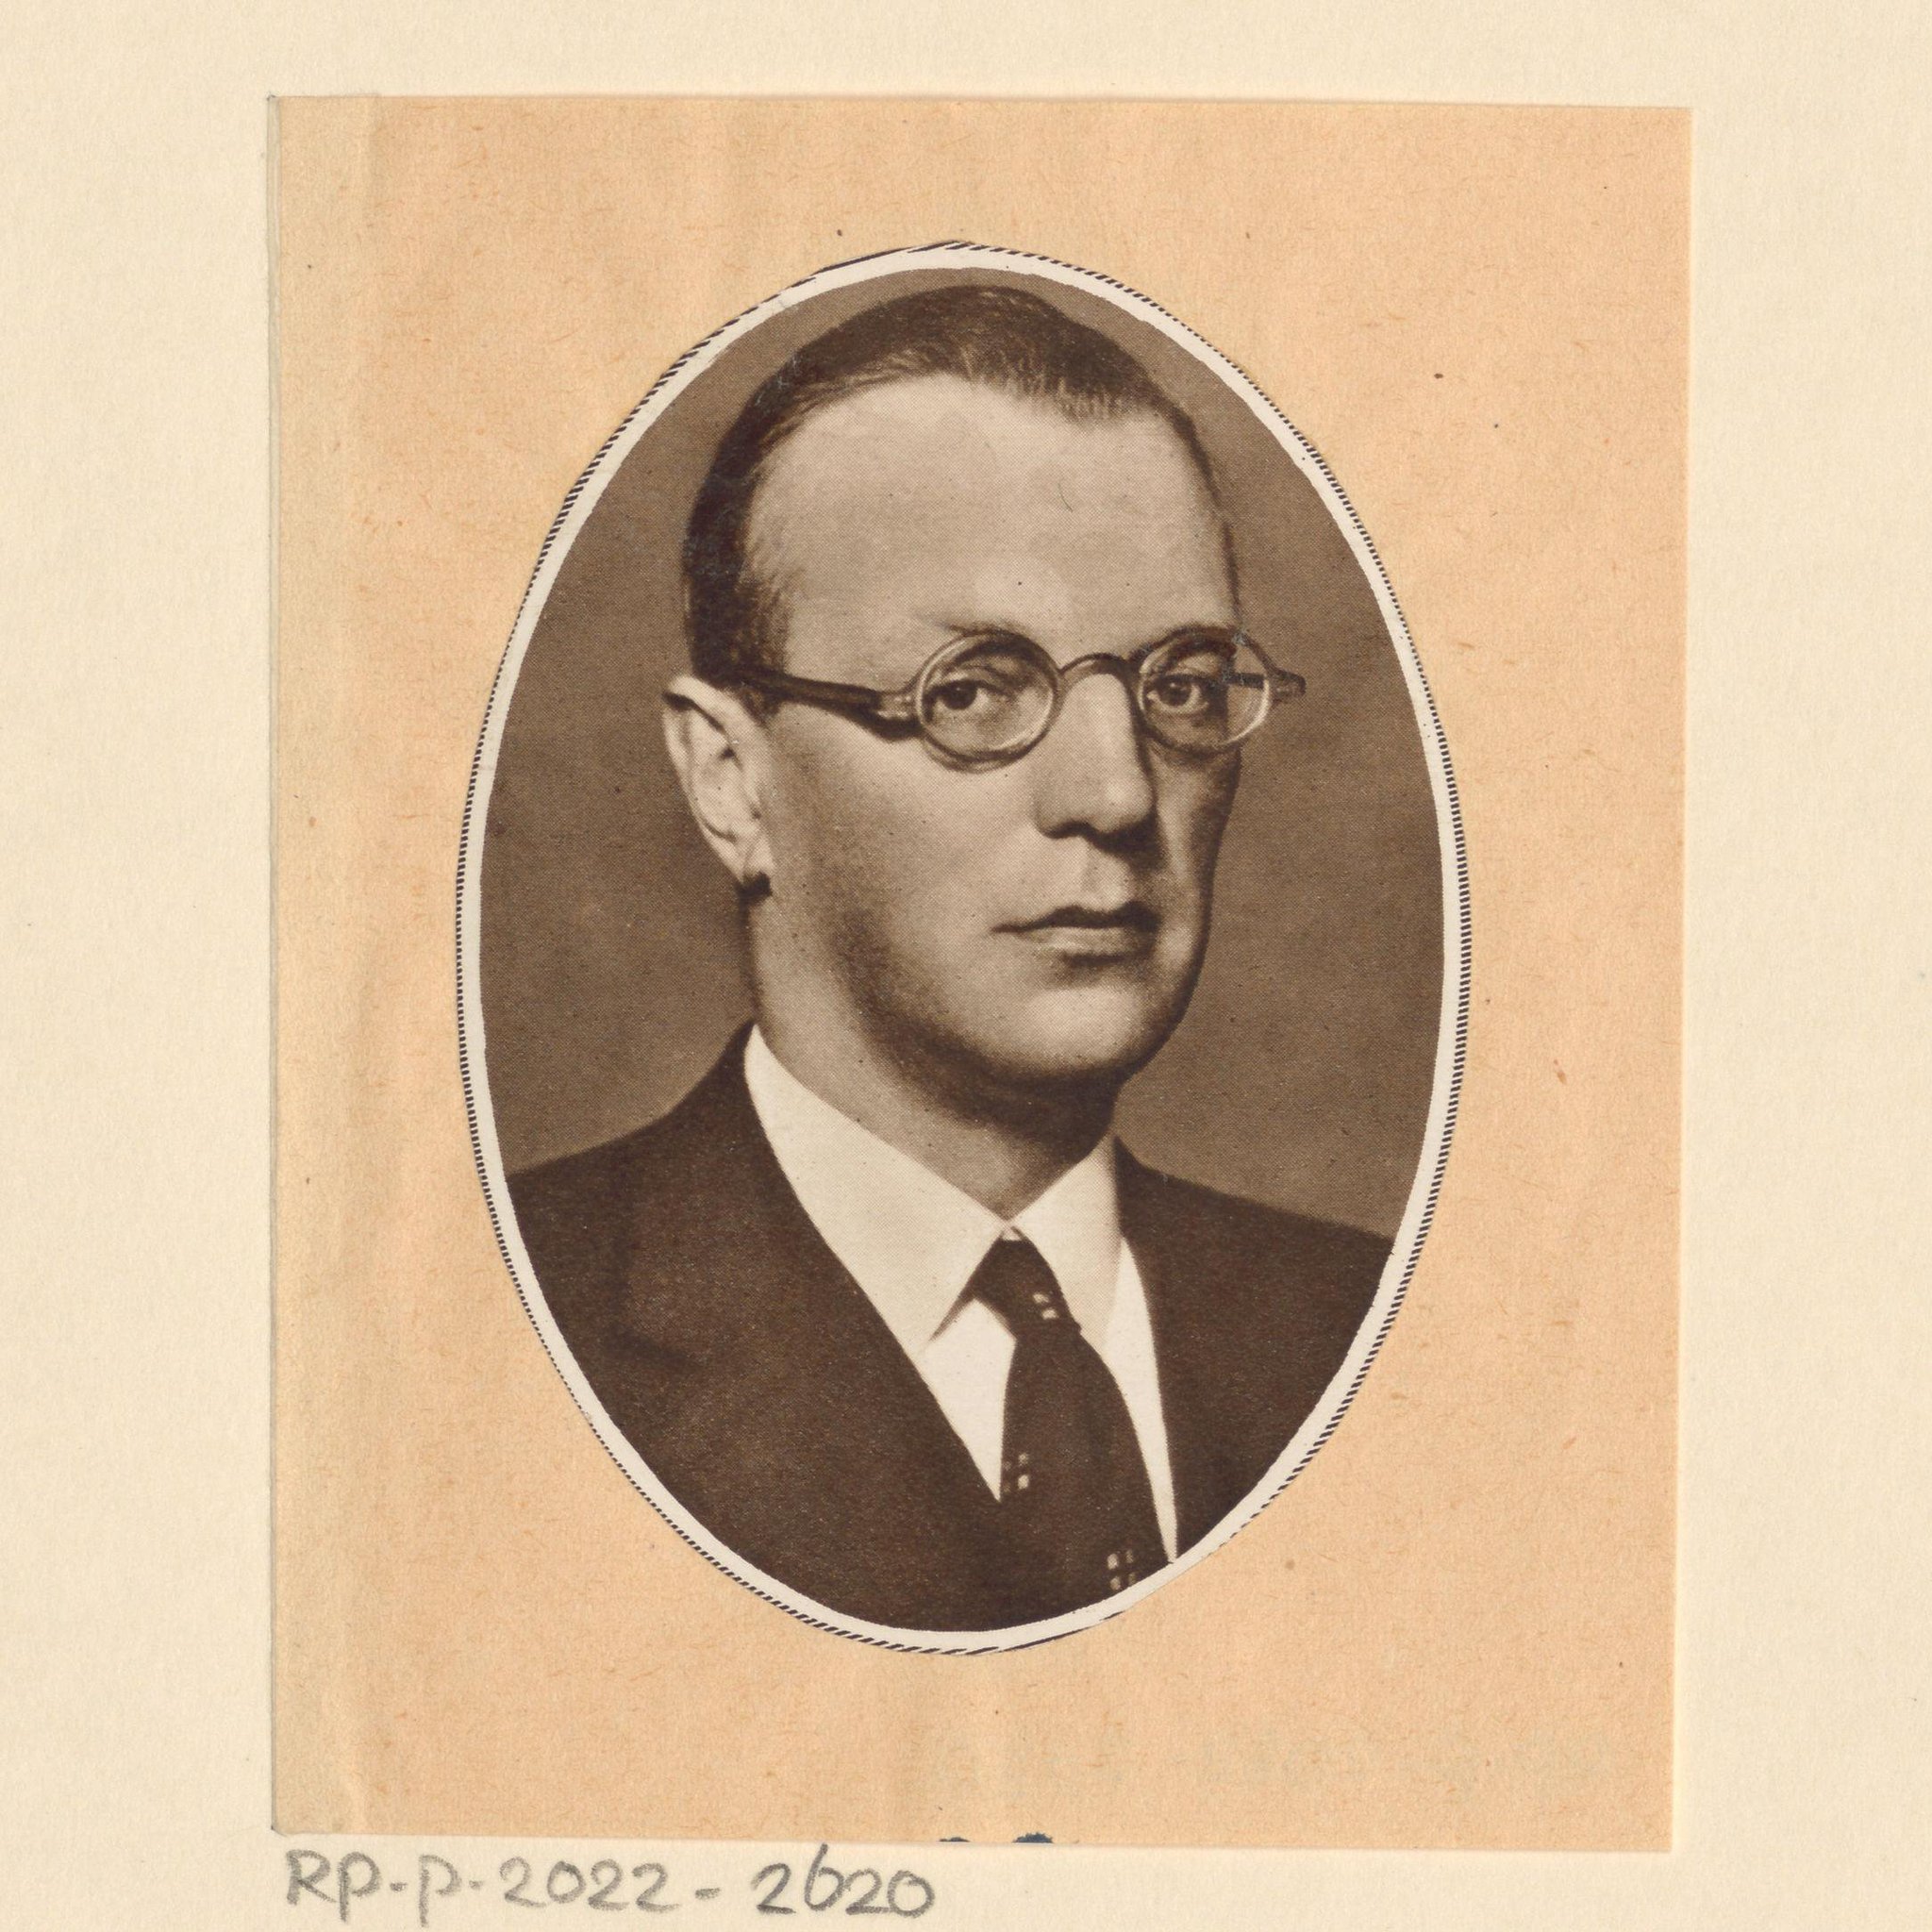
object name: photomechanical print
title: Portret van Arthur Seyss-Inquart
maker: Anonymous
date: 1930-1970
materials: paper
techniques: rotogravure, snipping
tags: politician, arthur seyss-inquart, historical persons, politician, e.g. party leader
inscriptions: inscription: ‘Dr. Seyss-Inquart’